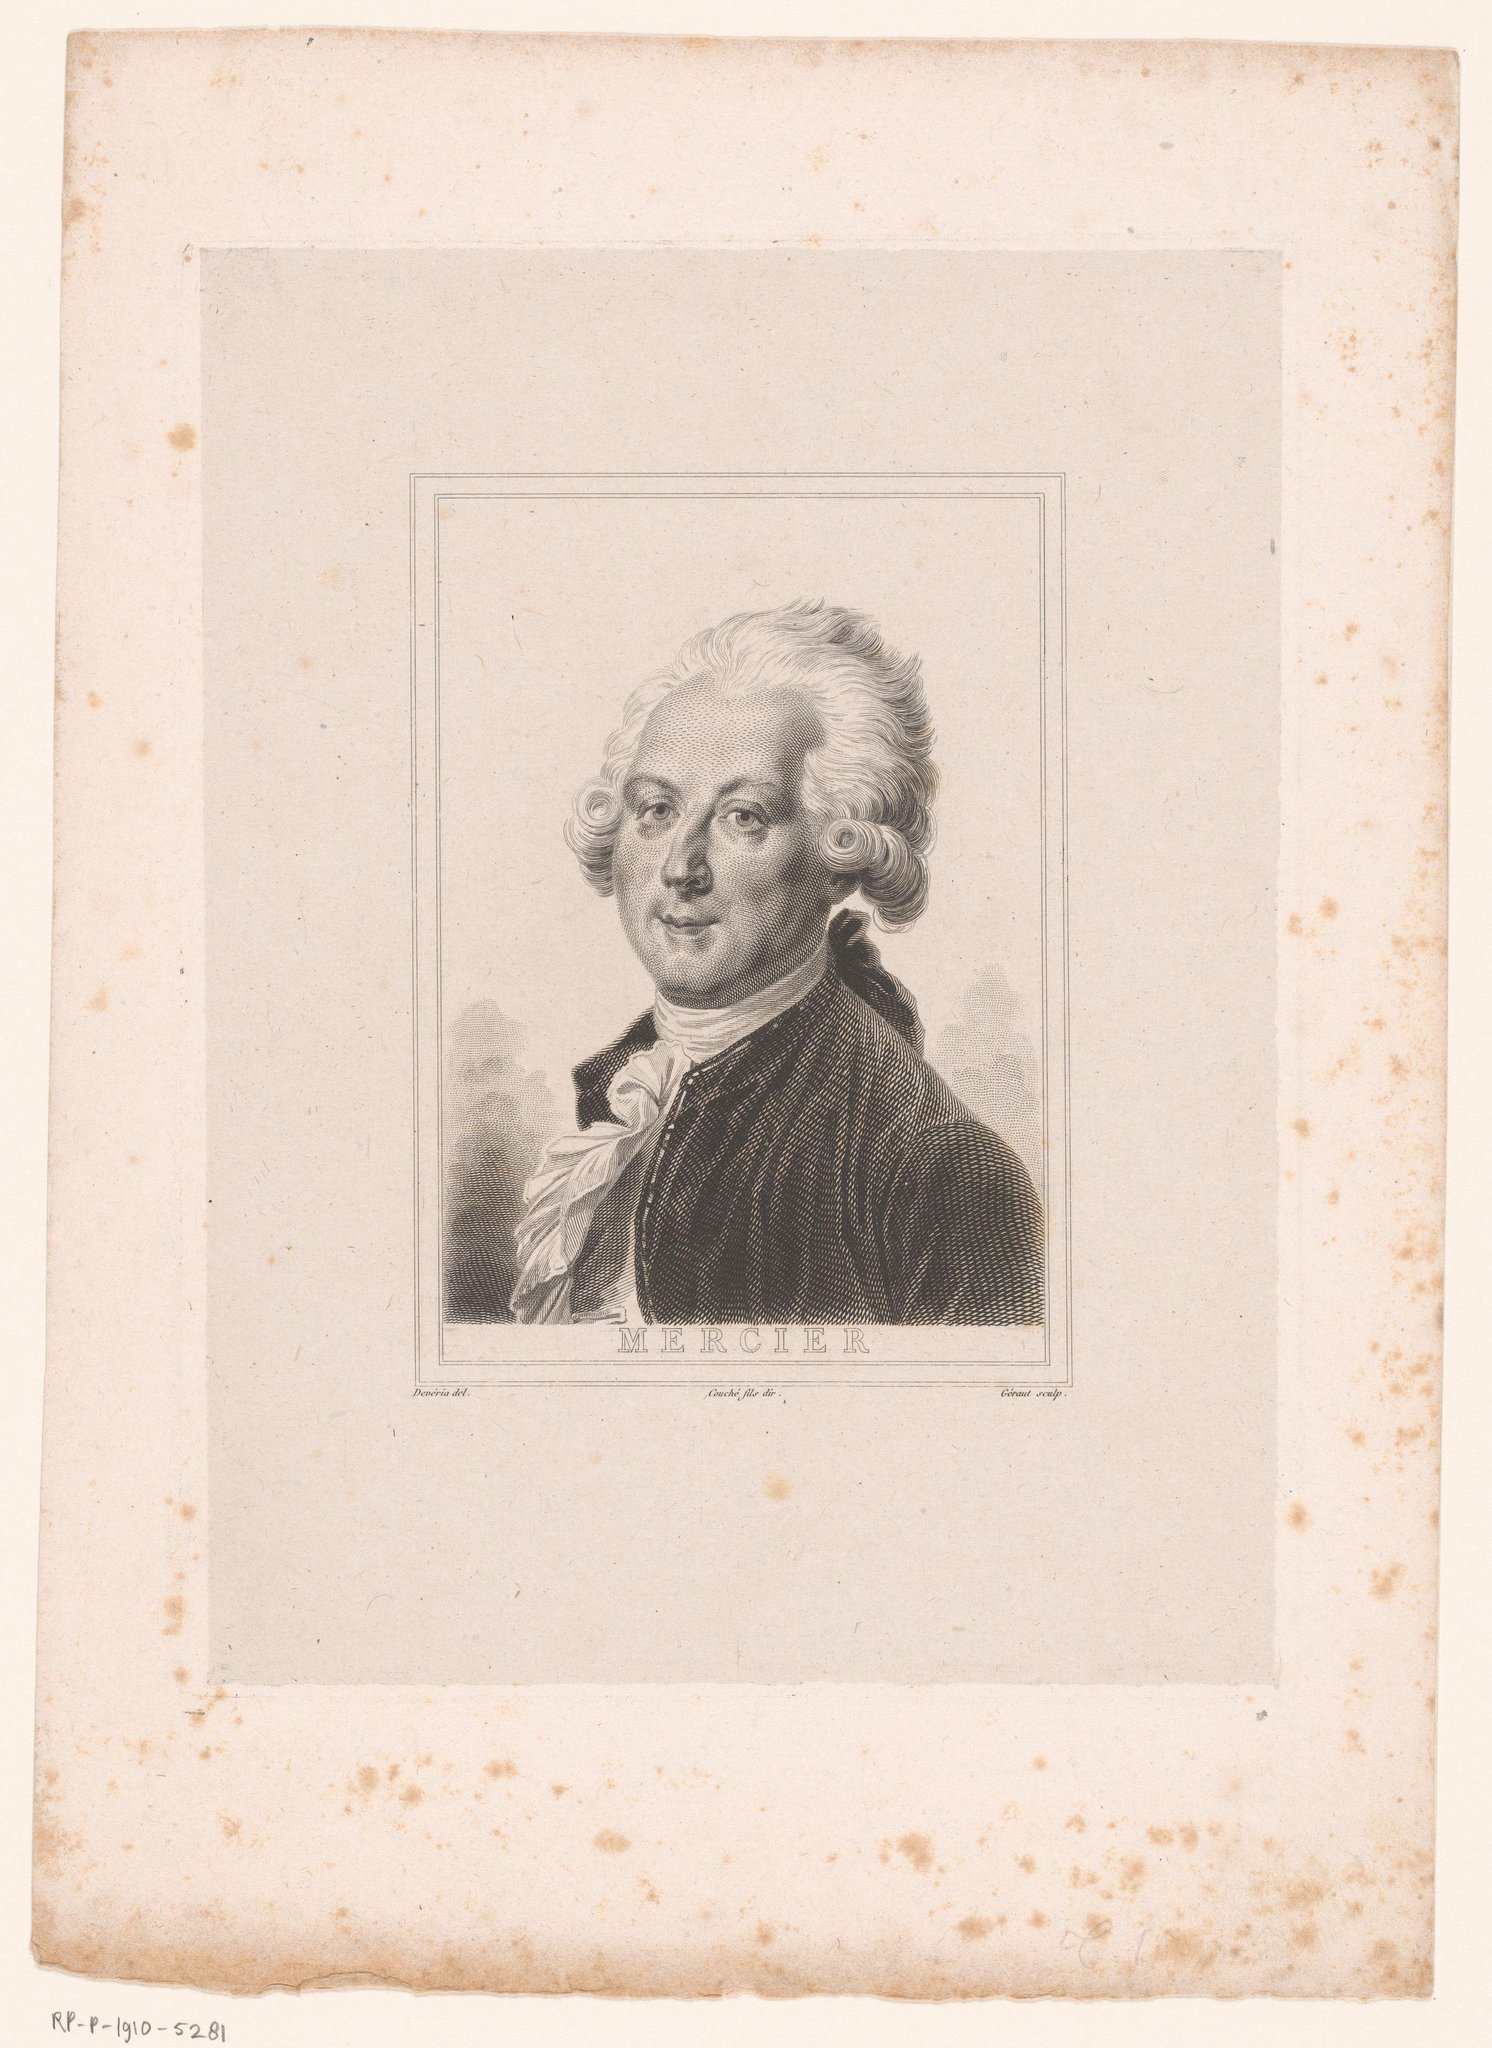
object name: print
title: Portret van Louis-Sébastien Mercier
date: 1796-1851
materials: paper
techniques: engraving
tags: paris, historical persons, portrait of a writer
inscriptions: collector's mark: Lugt 2228